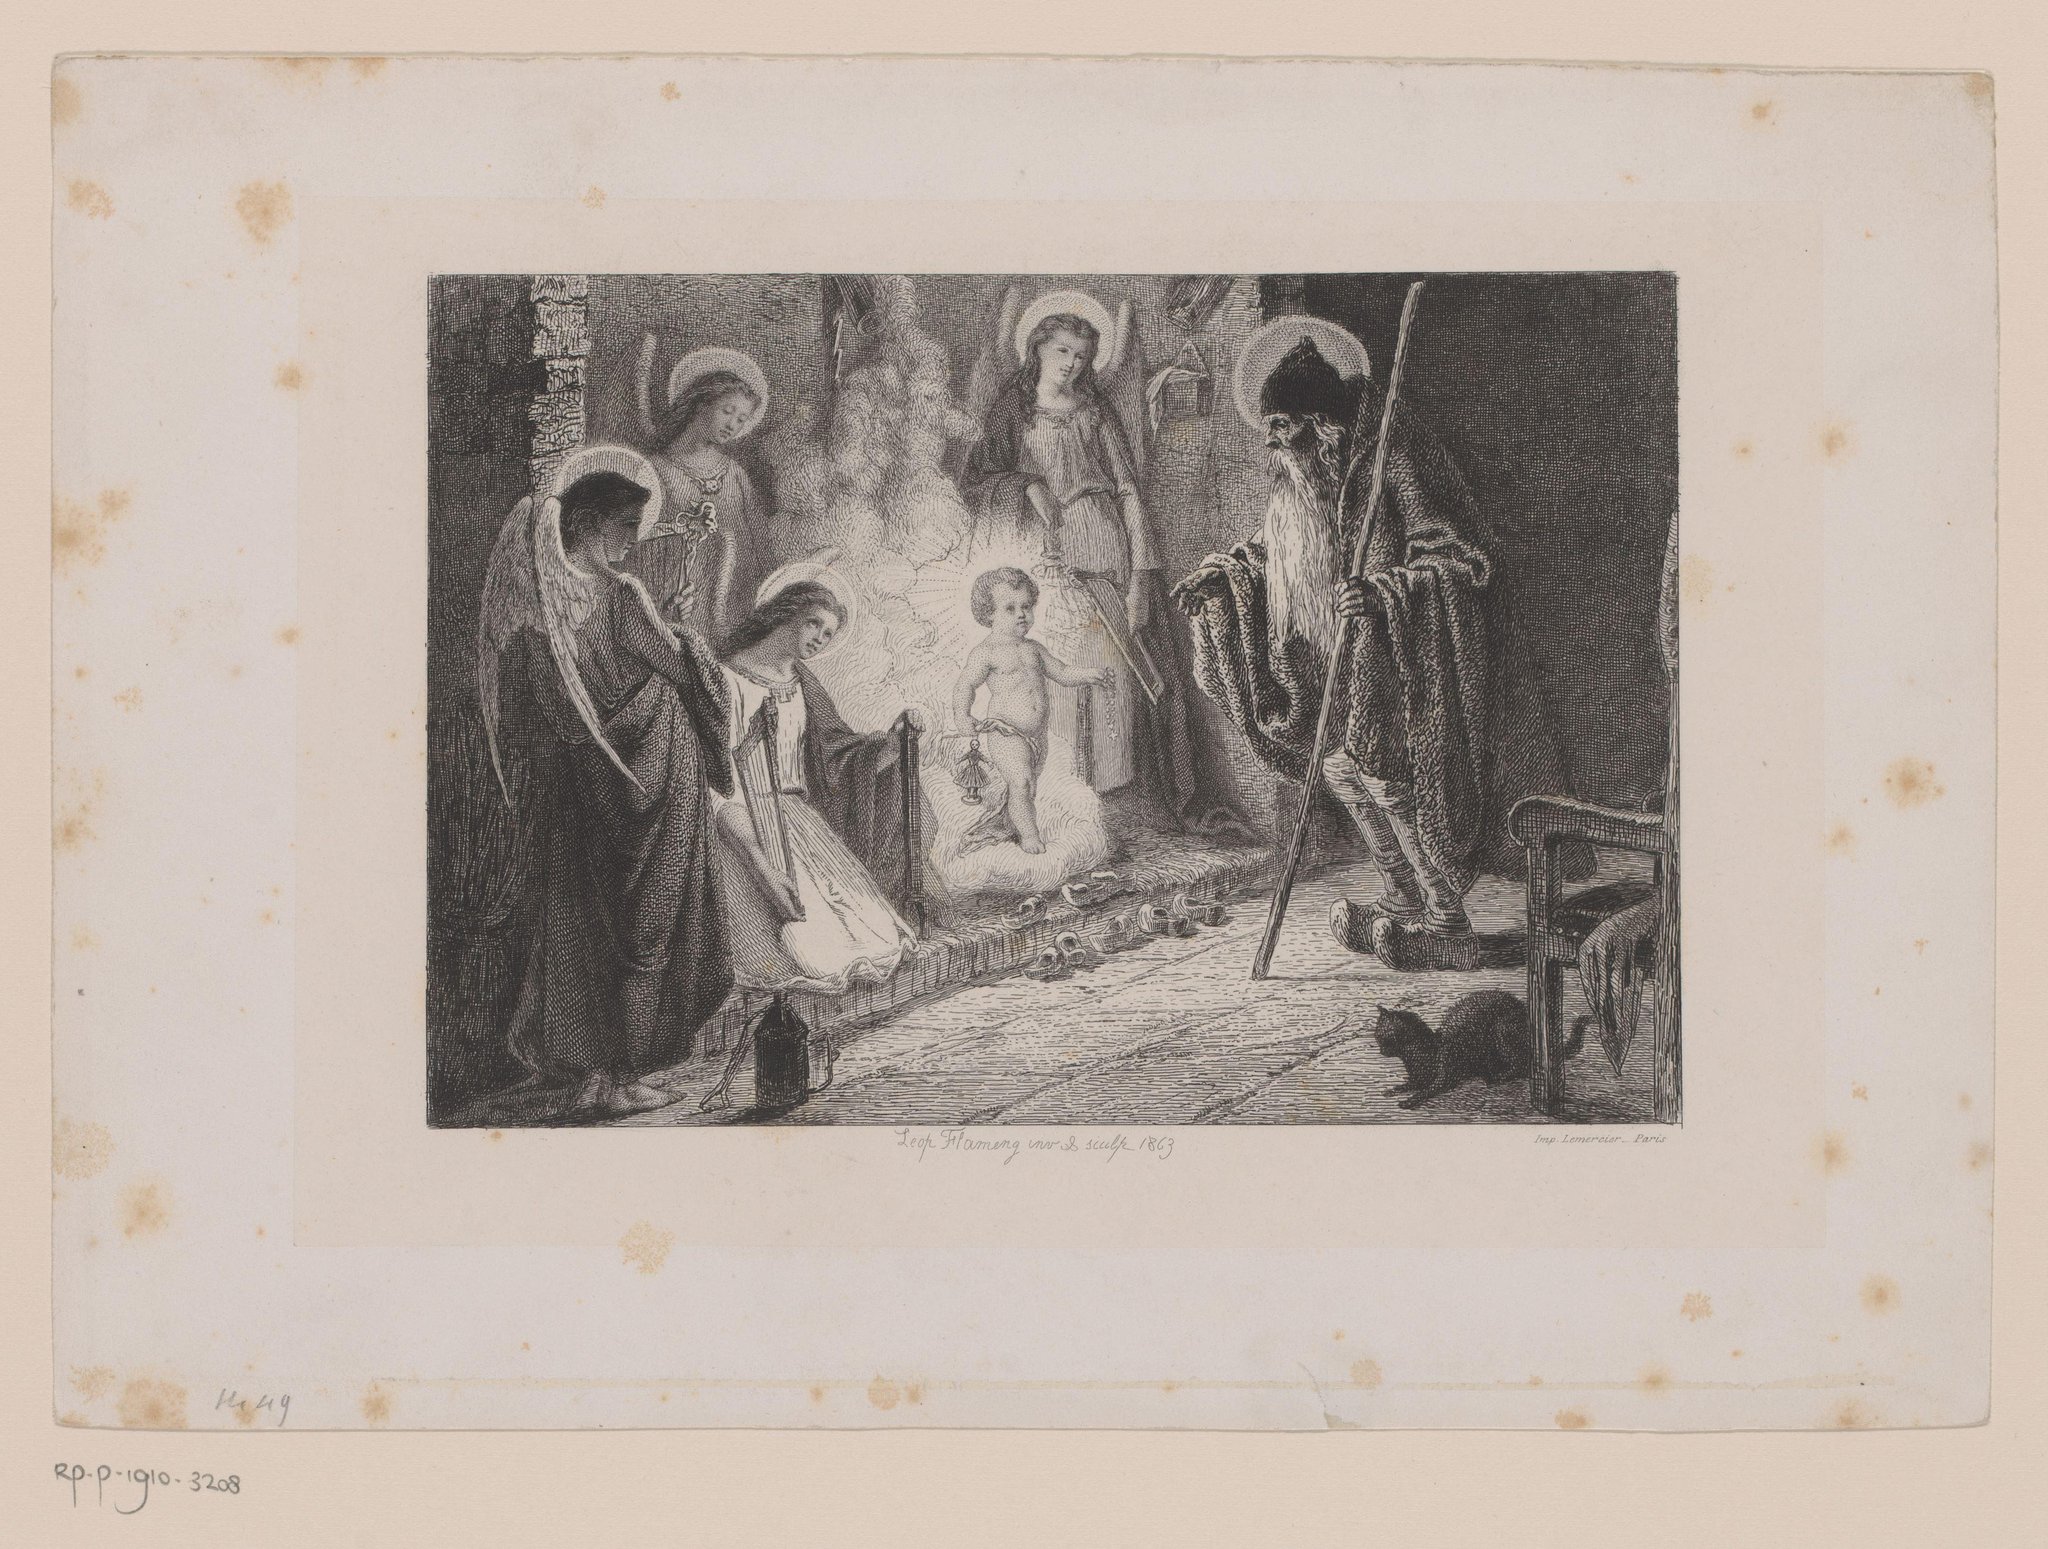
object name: book illustration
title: Christus, omringd door engelen, met St. Nicolaas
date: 1863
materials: paper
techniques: etching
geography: paris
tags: st. nicholas frees three soldiers from prison by appearing to emperor constantine in a dream; constantine sends the three released men with gifts to st. nicholas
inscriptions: collector's mark: Lugt 2228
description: Prent uit: Giron, Aimé. Le sabot de Noël. Paris: Ducrocq, 1863, p. 55.